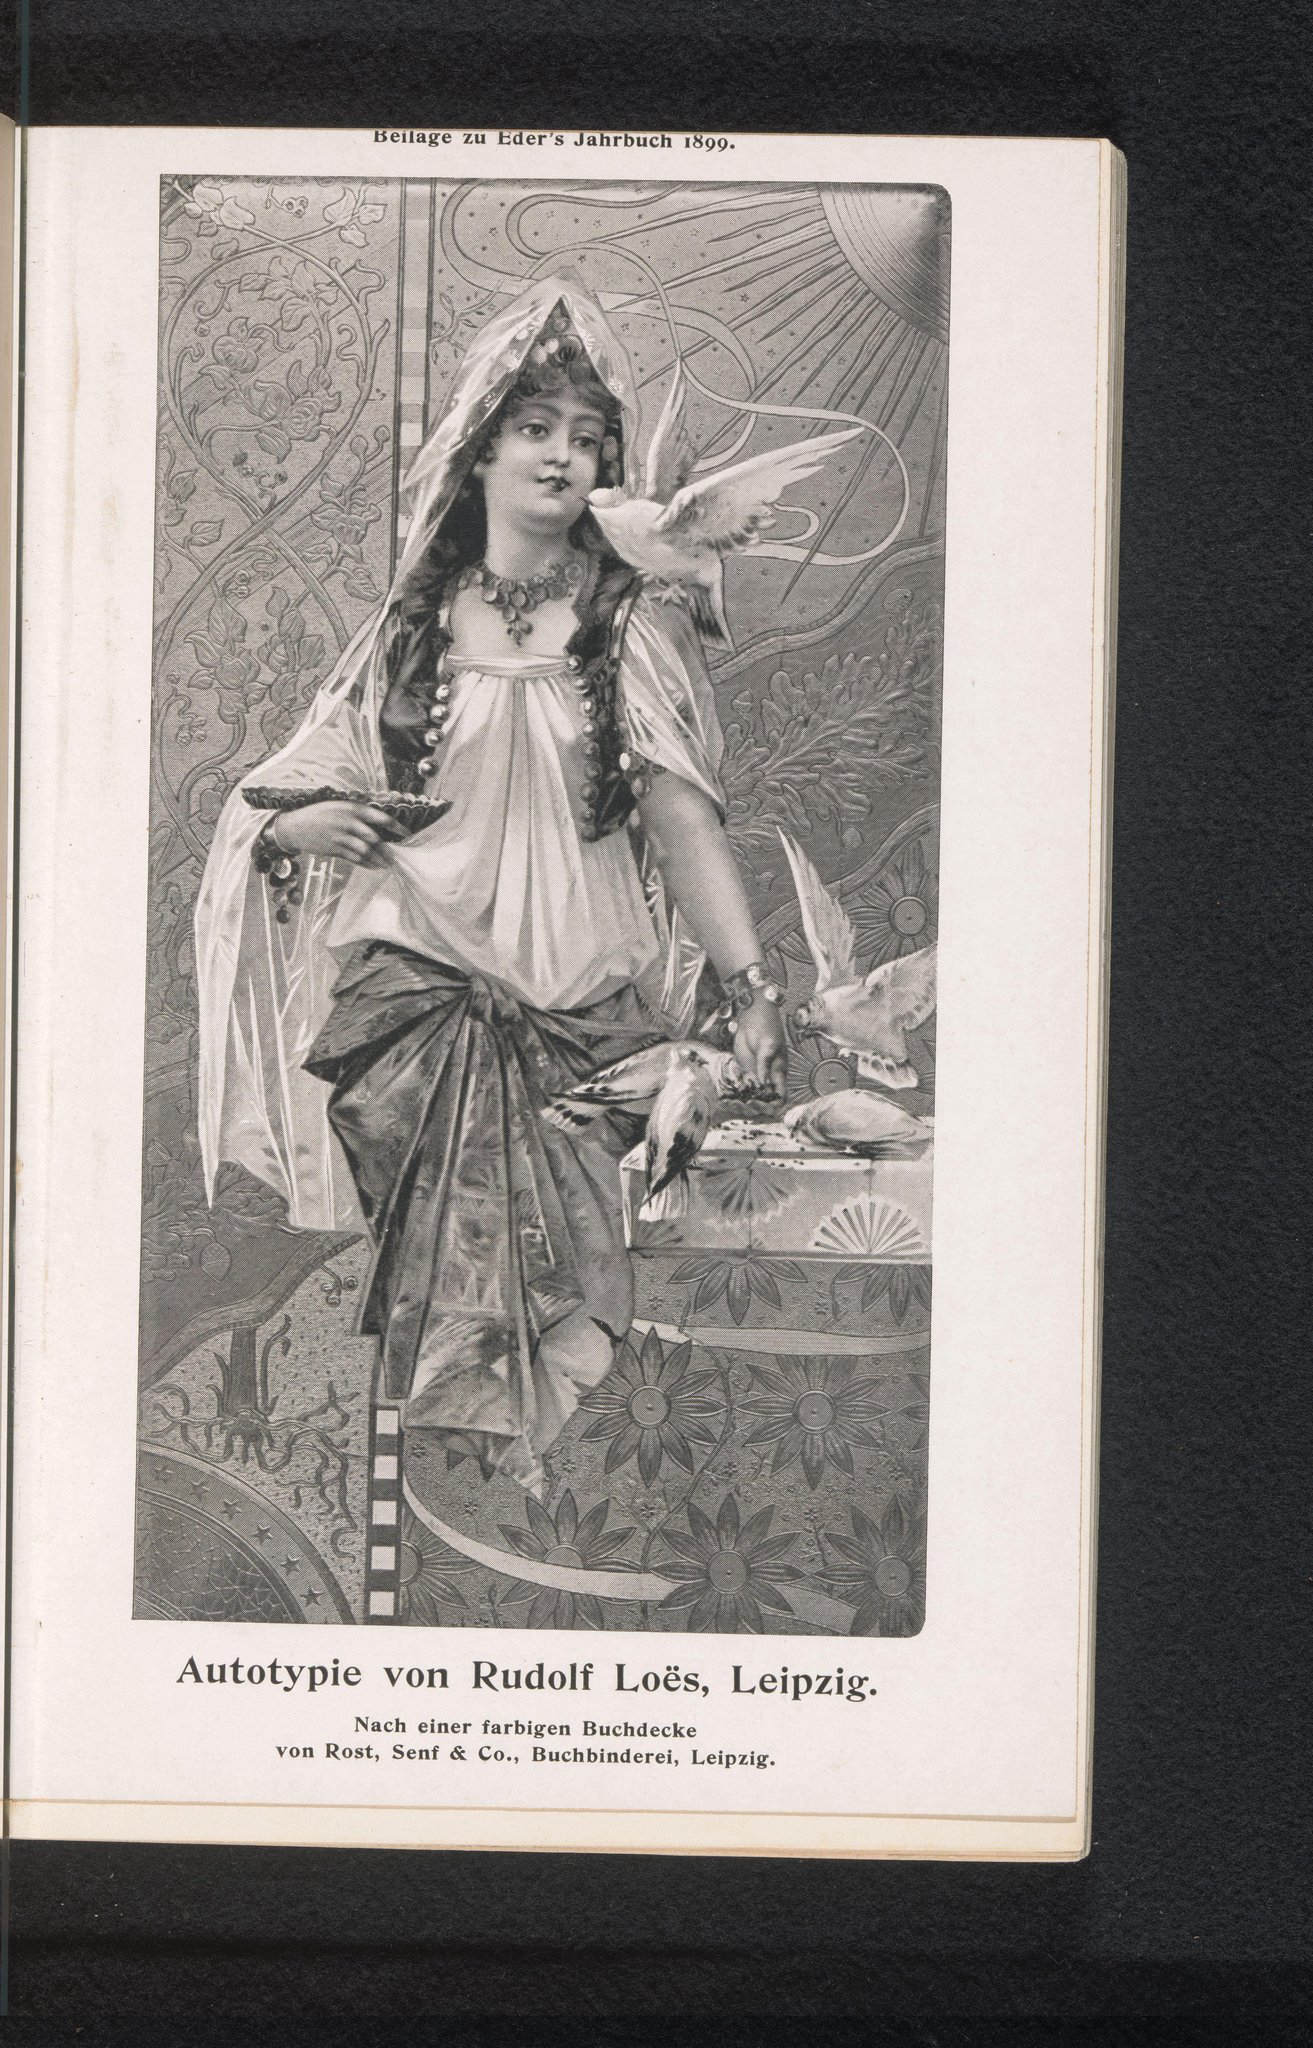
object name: photomechanical print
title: Reproductie van een voorstelling van een onbekende vrouw die vogels voedt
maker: Anonymous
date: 1894-1899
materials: paper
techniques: autotype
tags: birds, adult man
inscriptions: inscription: ‘Beilage zu Eder's Jahrbuch 1899./ Autotypie von Rudolf Loës, Leipzig./ Nach einer farbigen Buchdecke von Rost, Senf & Co., Buchbinderei, Leipzig.’